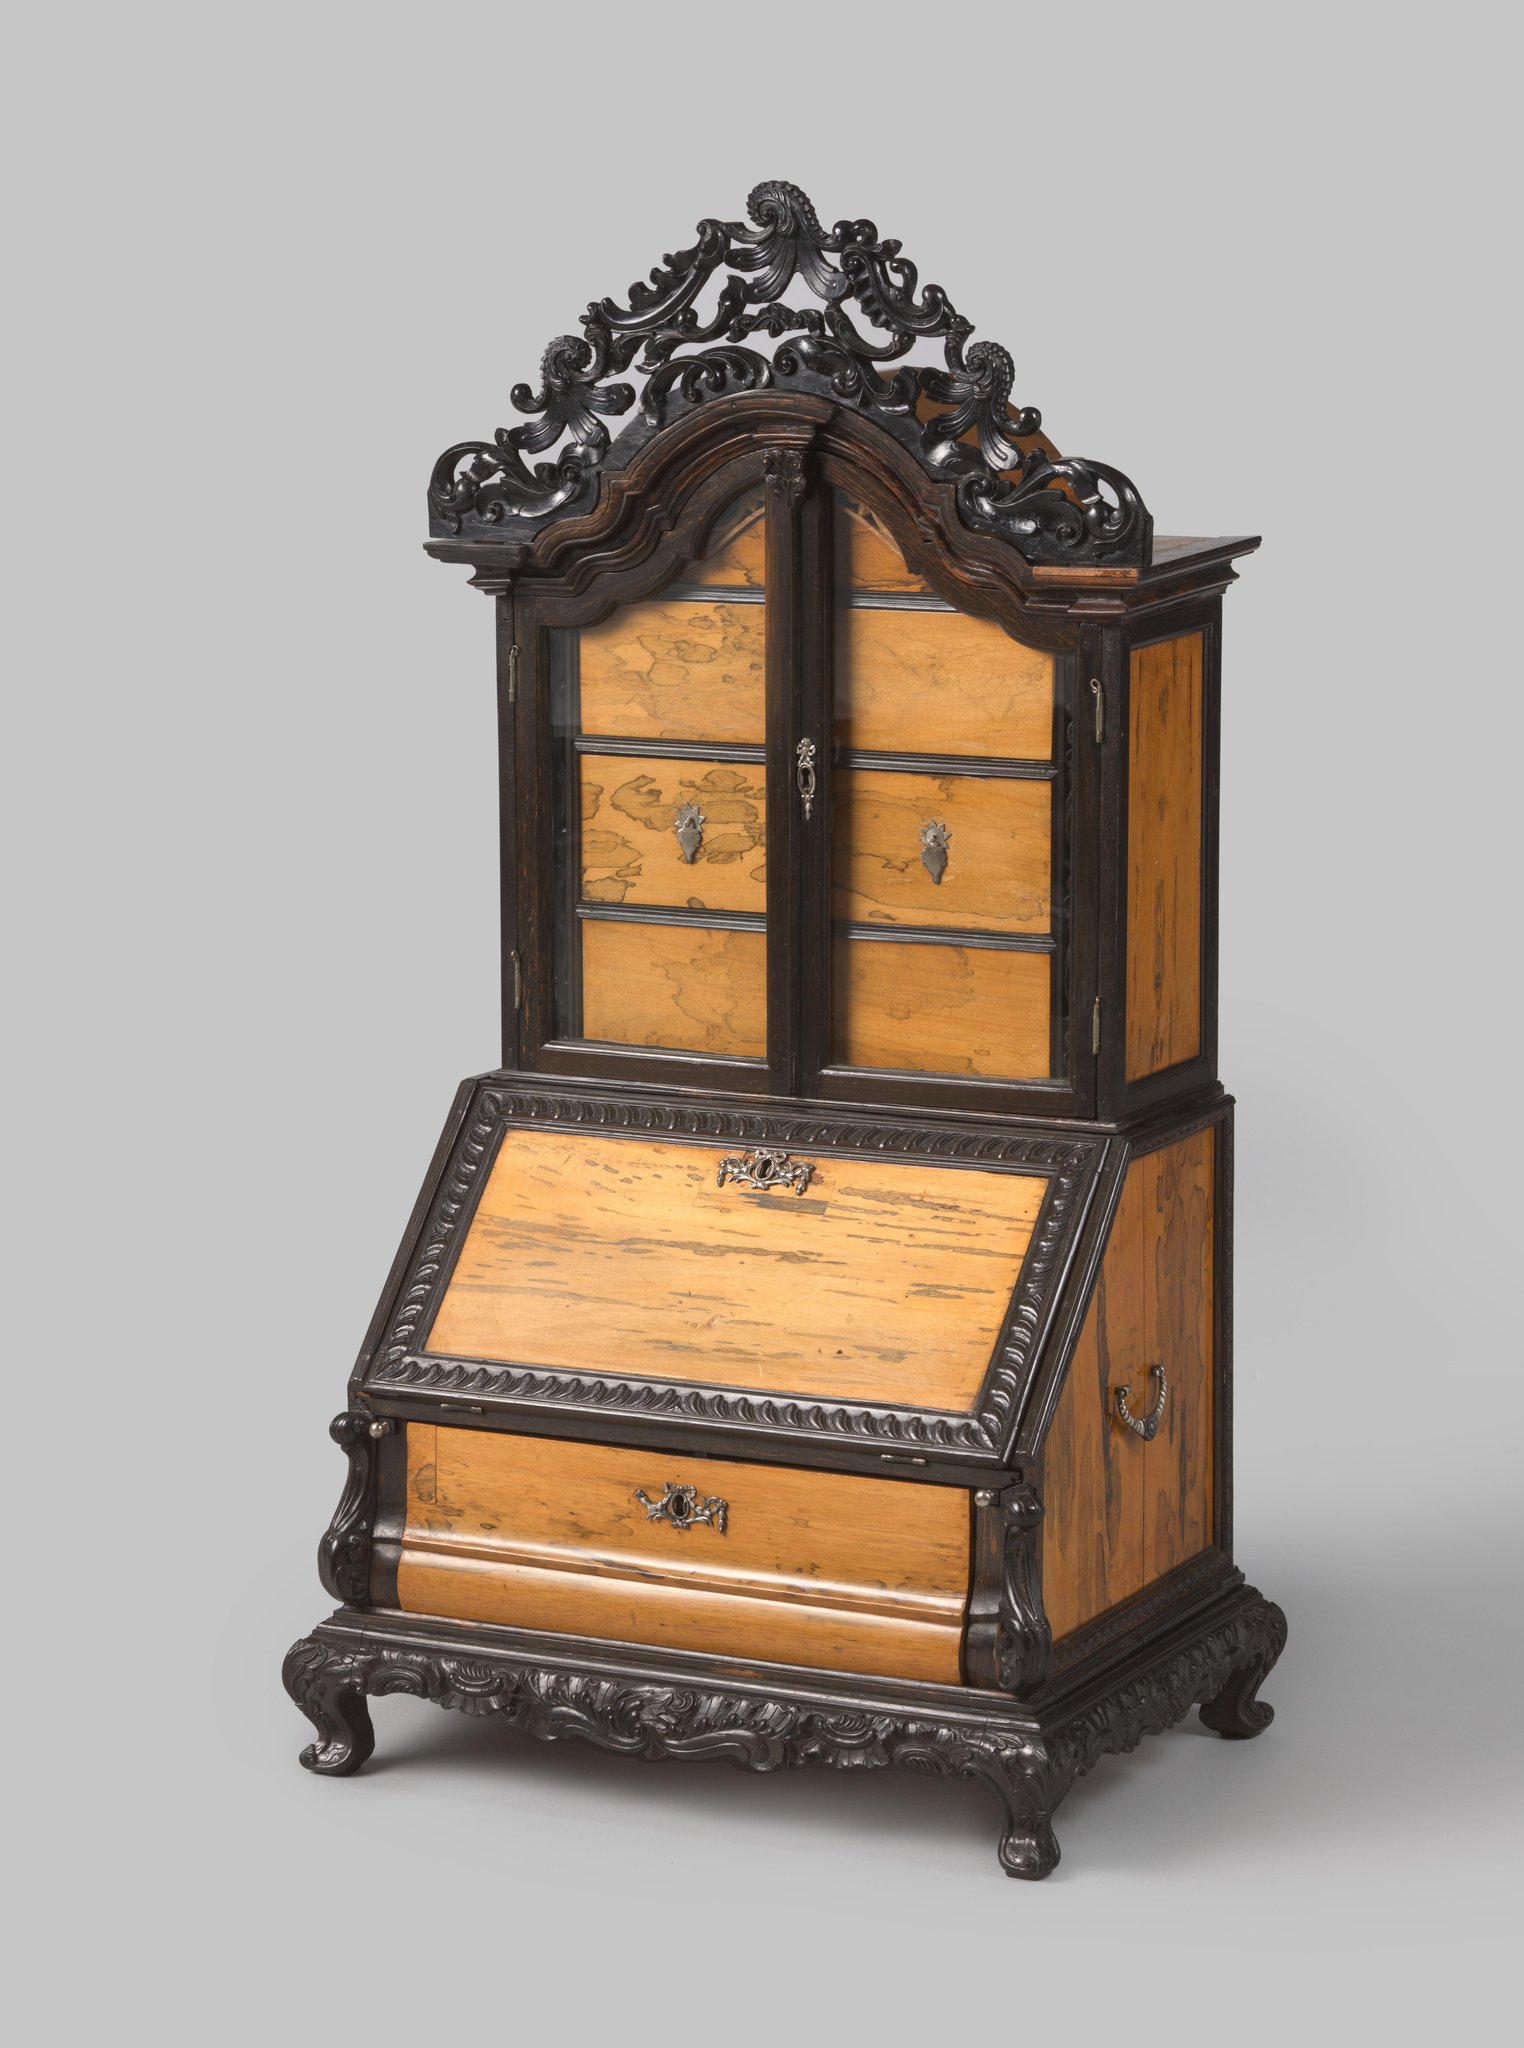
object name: desk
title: Dubbelgebogen onderkast met lade horend bij bureau; bovenzijde met schuine klep met knorrenrand; beslag van zilver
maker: Anonymous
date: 1750-1800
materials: wood, glass, silver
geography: indonesia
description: Onderdeel van bureau, miniatuur met opstand van ebbenhout en het spint van tropisch hout. Het losse voetstuk met overhoeks geplaatste gedrongen gebogen poten toont bloem- en bladwerk, voluten en rocailles. Hierop staat de onderkast met een dubbelgebogen onderstuk en een lade met zilveren sleutelplaat; op de zijkanten getordeerde hengsels met rozetten, omlijst door knorren.